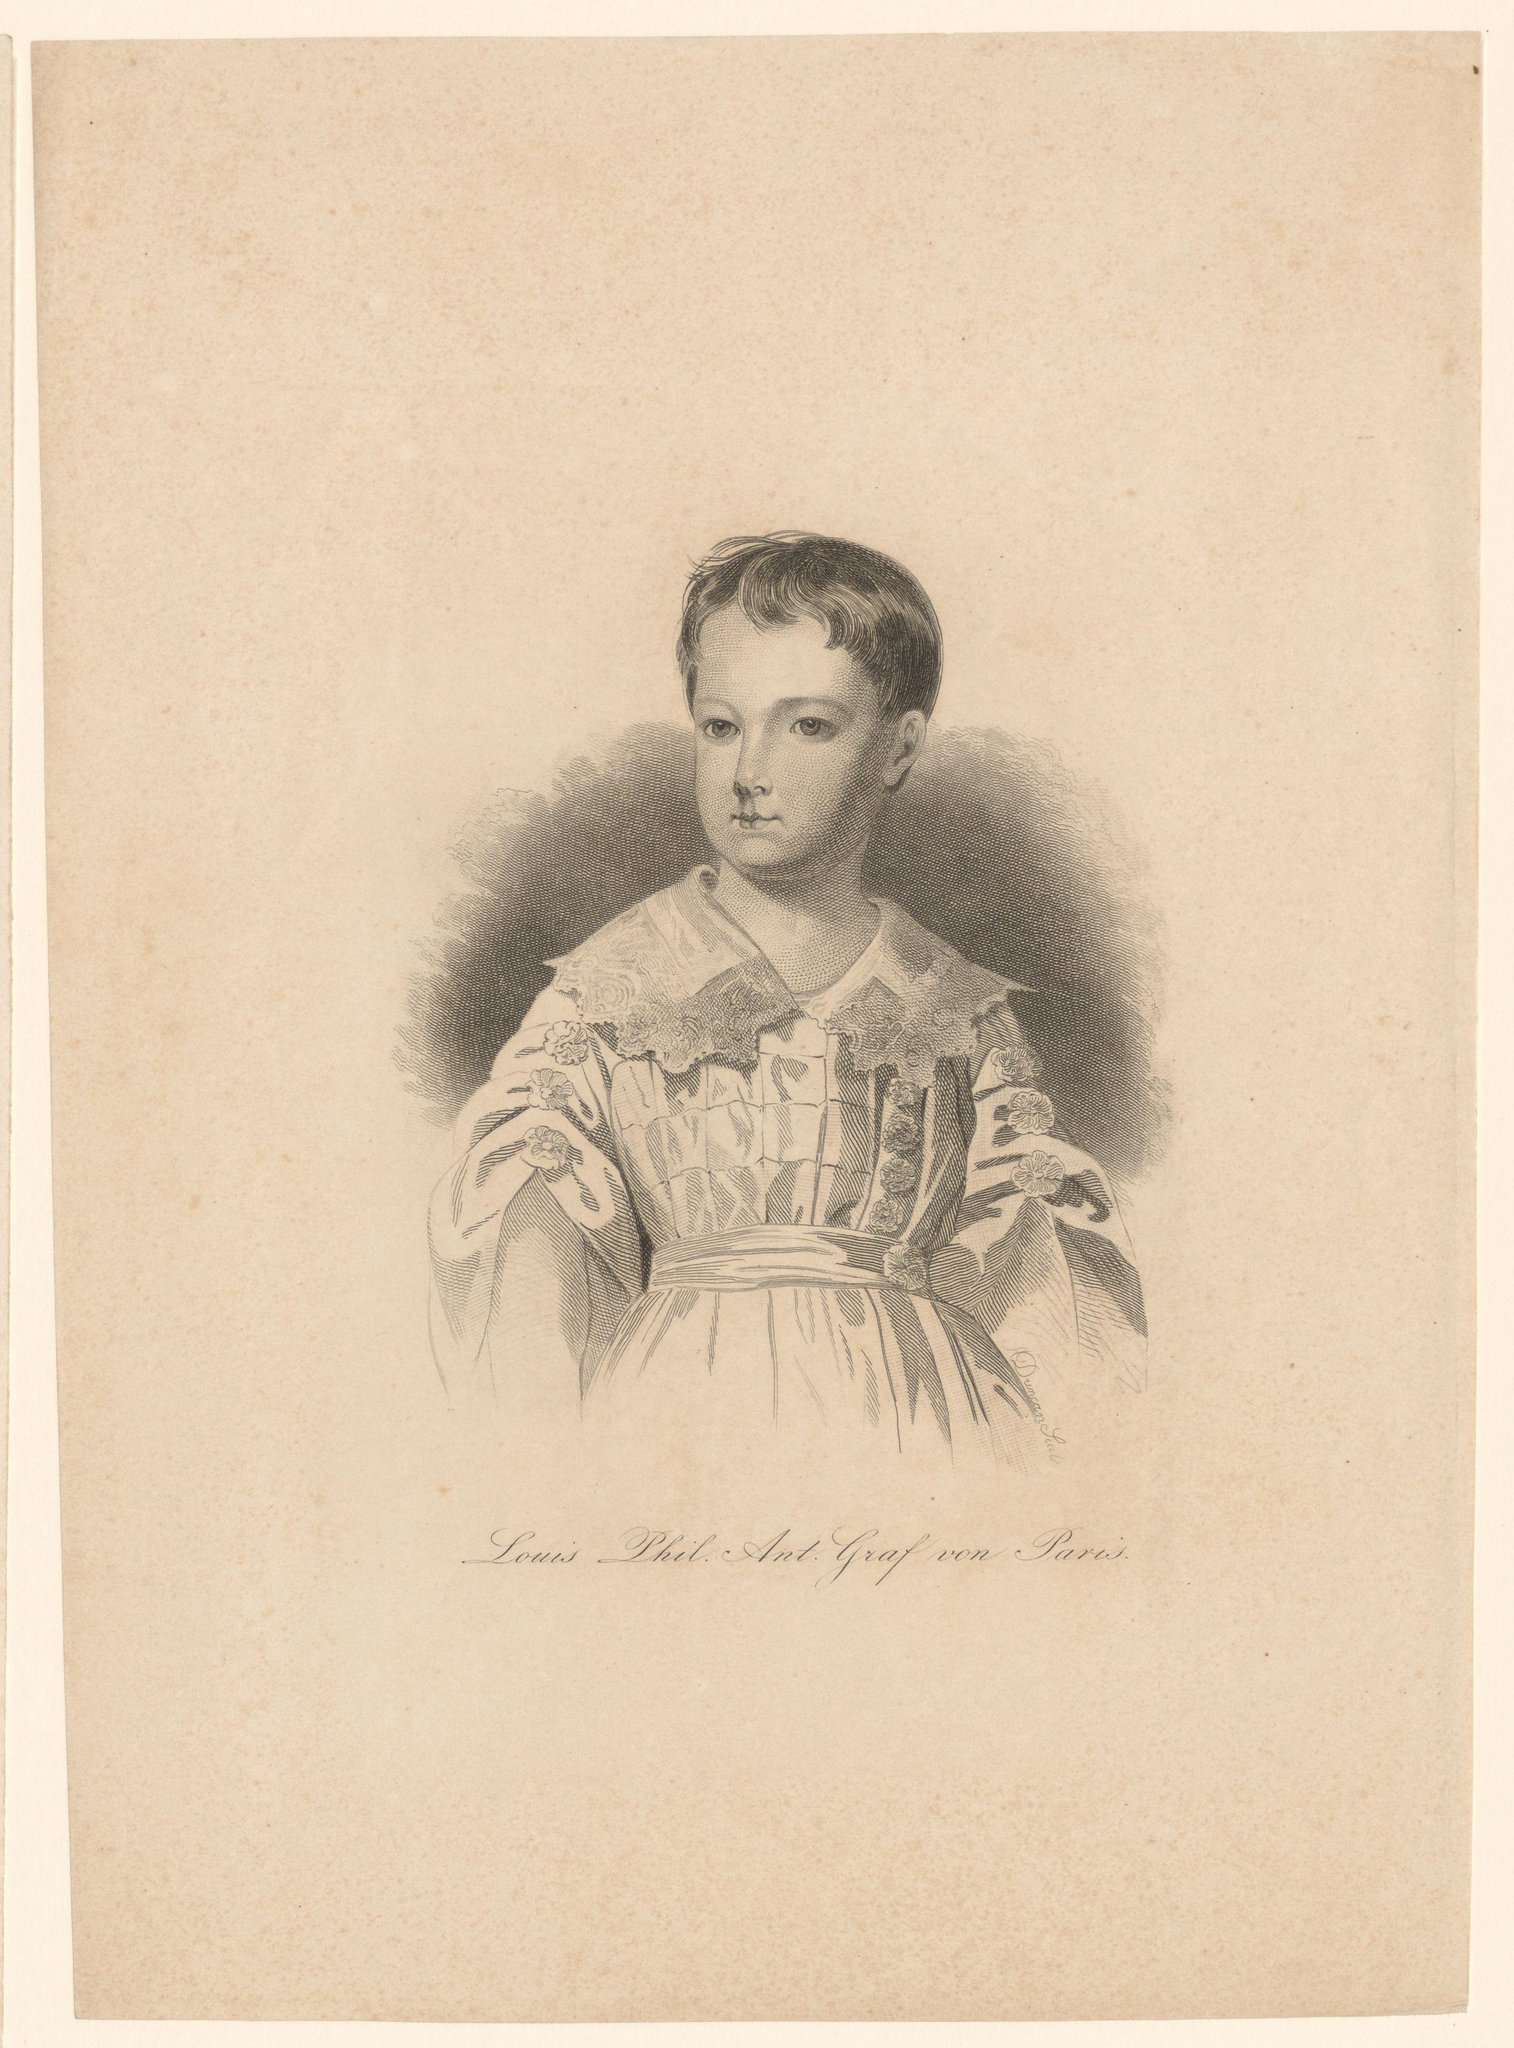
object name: print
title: Portret van Lodewijk Filips II van Orléans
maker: andrew duncan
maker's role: print maker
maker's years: 1795-1855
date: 1845-1895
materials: paper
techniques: engraving, etching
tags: paris, lodewijk filips ii (hertog van orléans), historical persons, ruler, sovereign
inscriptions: collector's mark: Lugt 2228